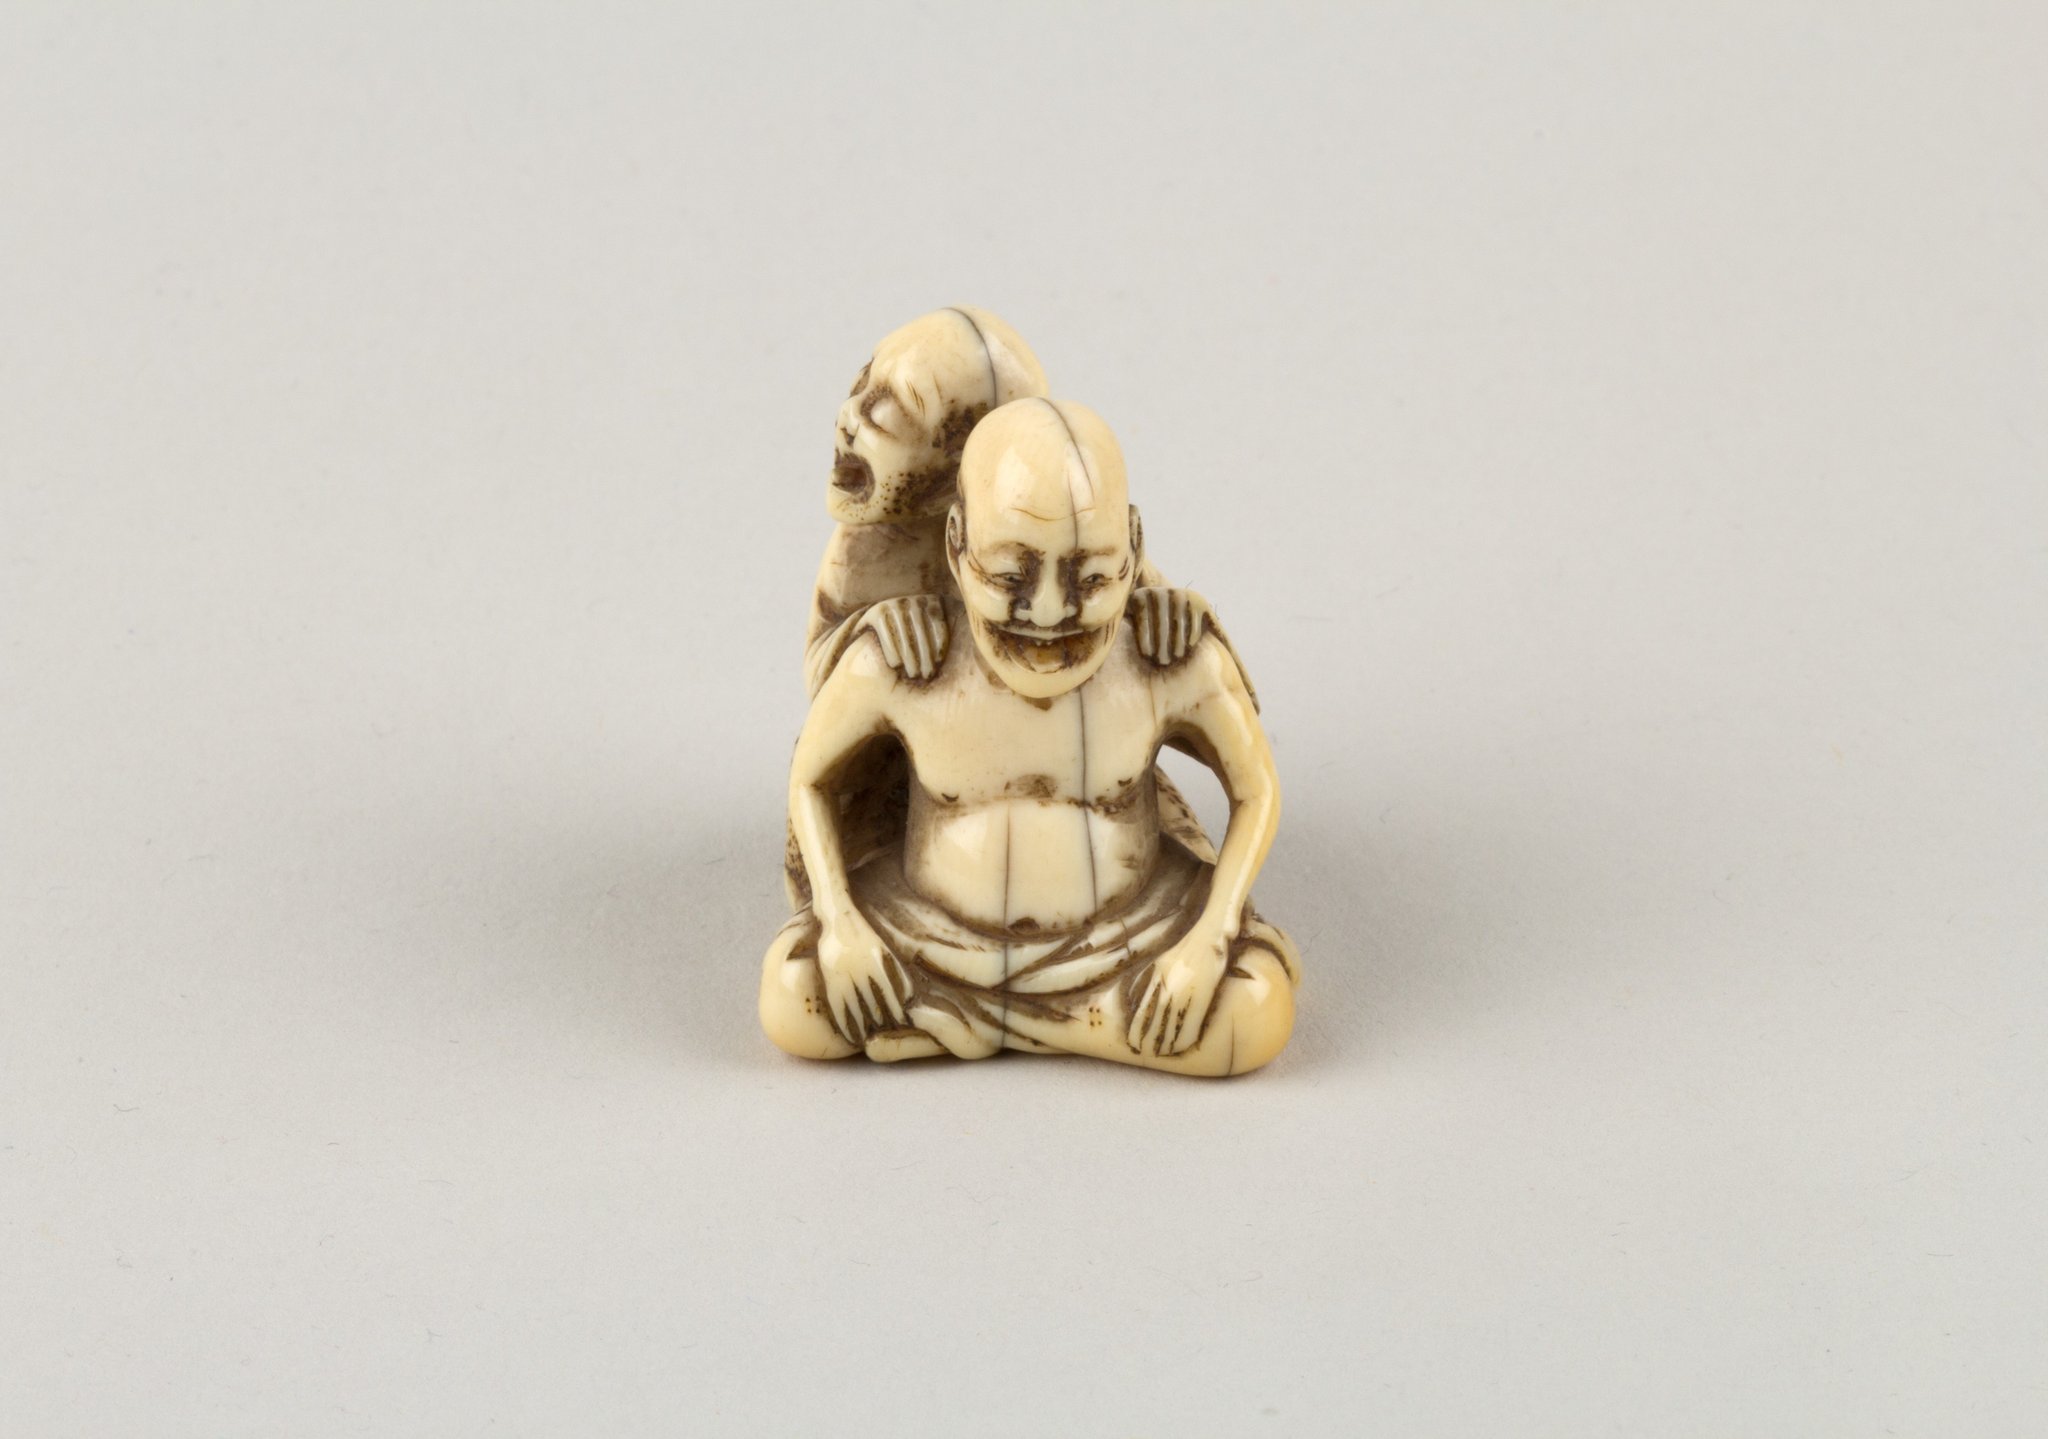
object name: netsuke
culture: japanese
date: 1801-1900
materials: ivory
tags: human figures